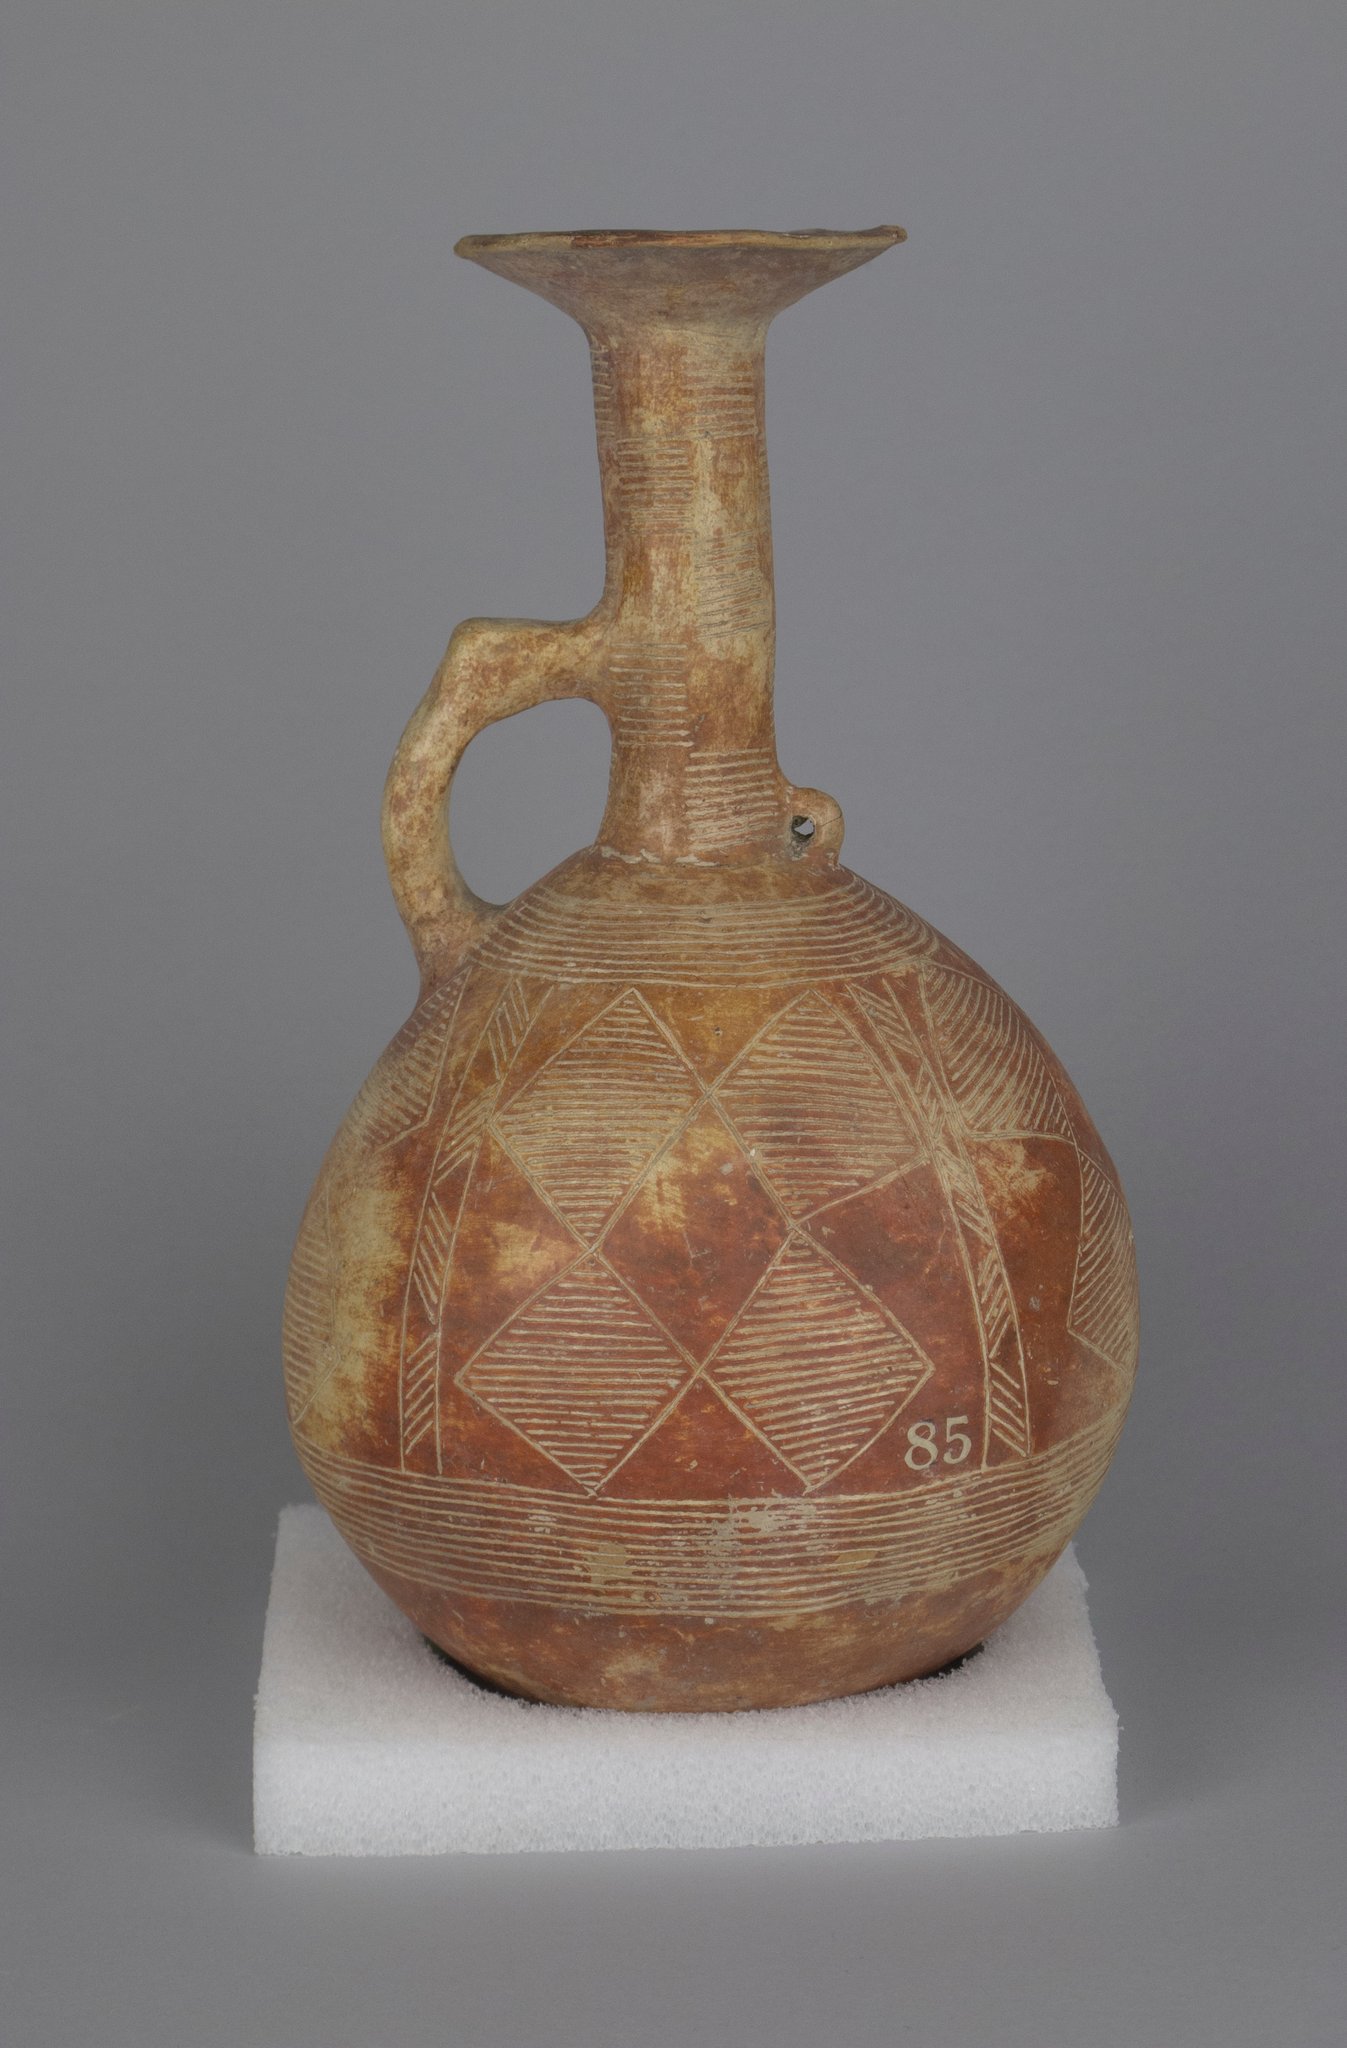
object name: jug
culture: cypriot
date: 2500-1900 BCE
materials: terracotta